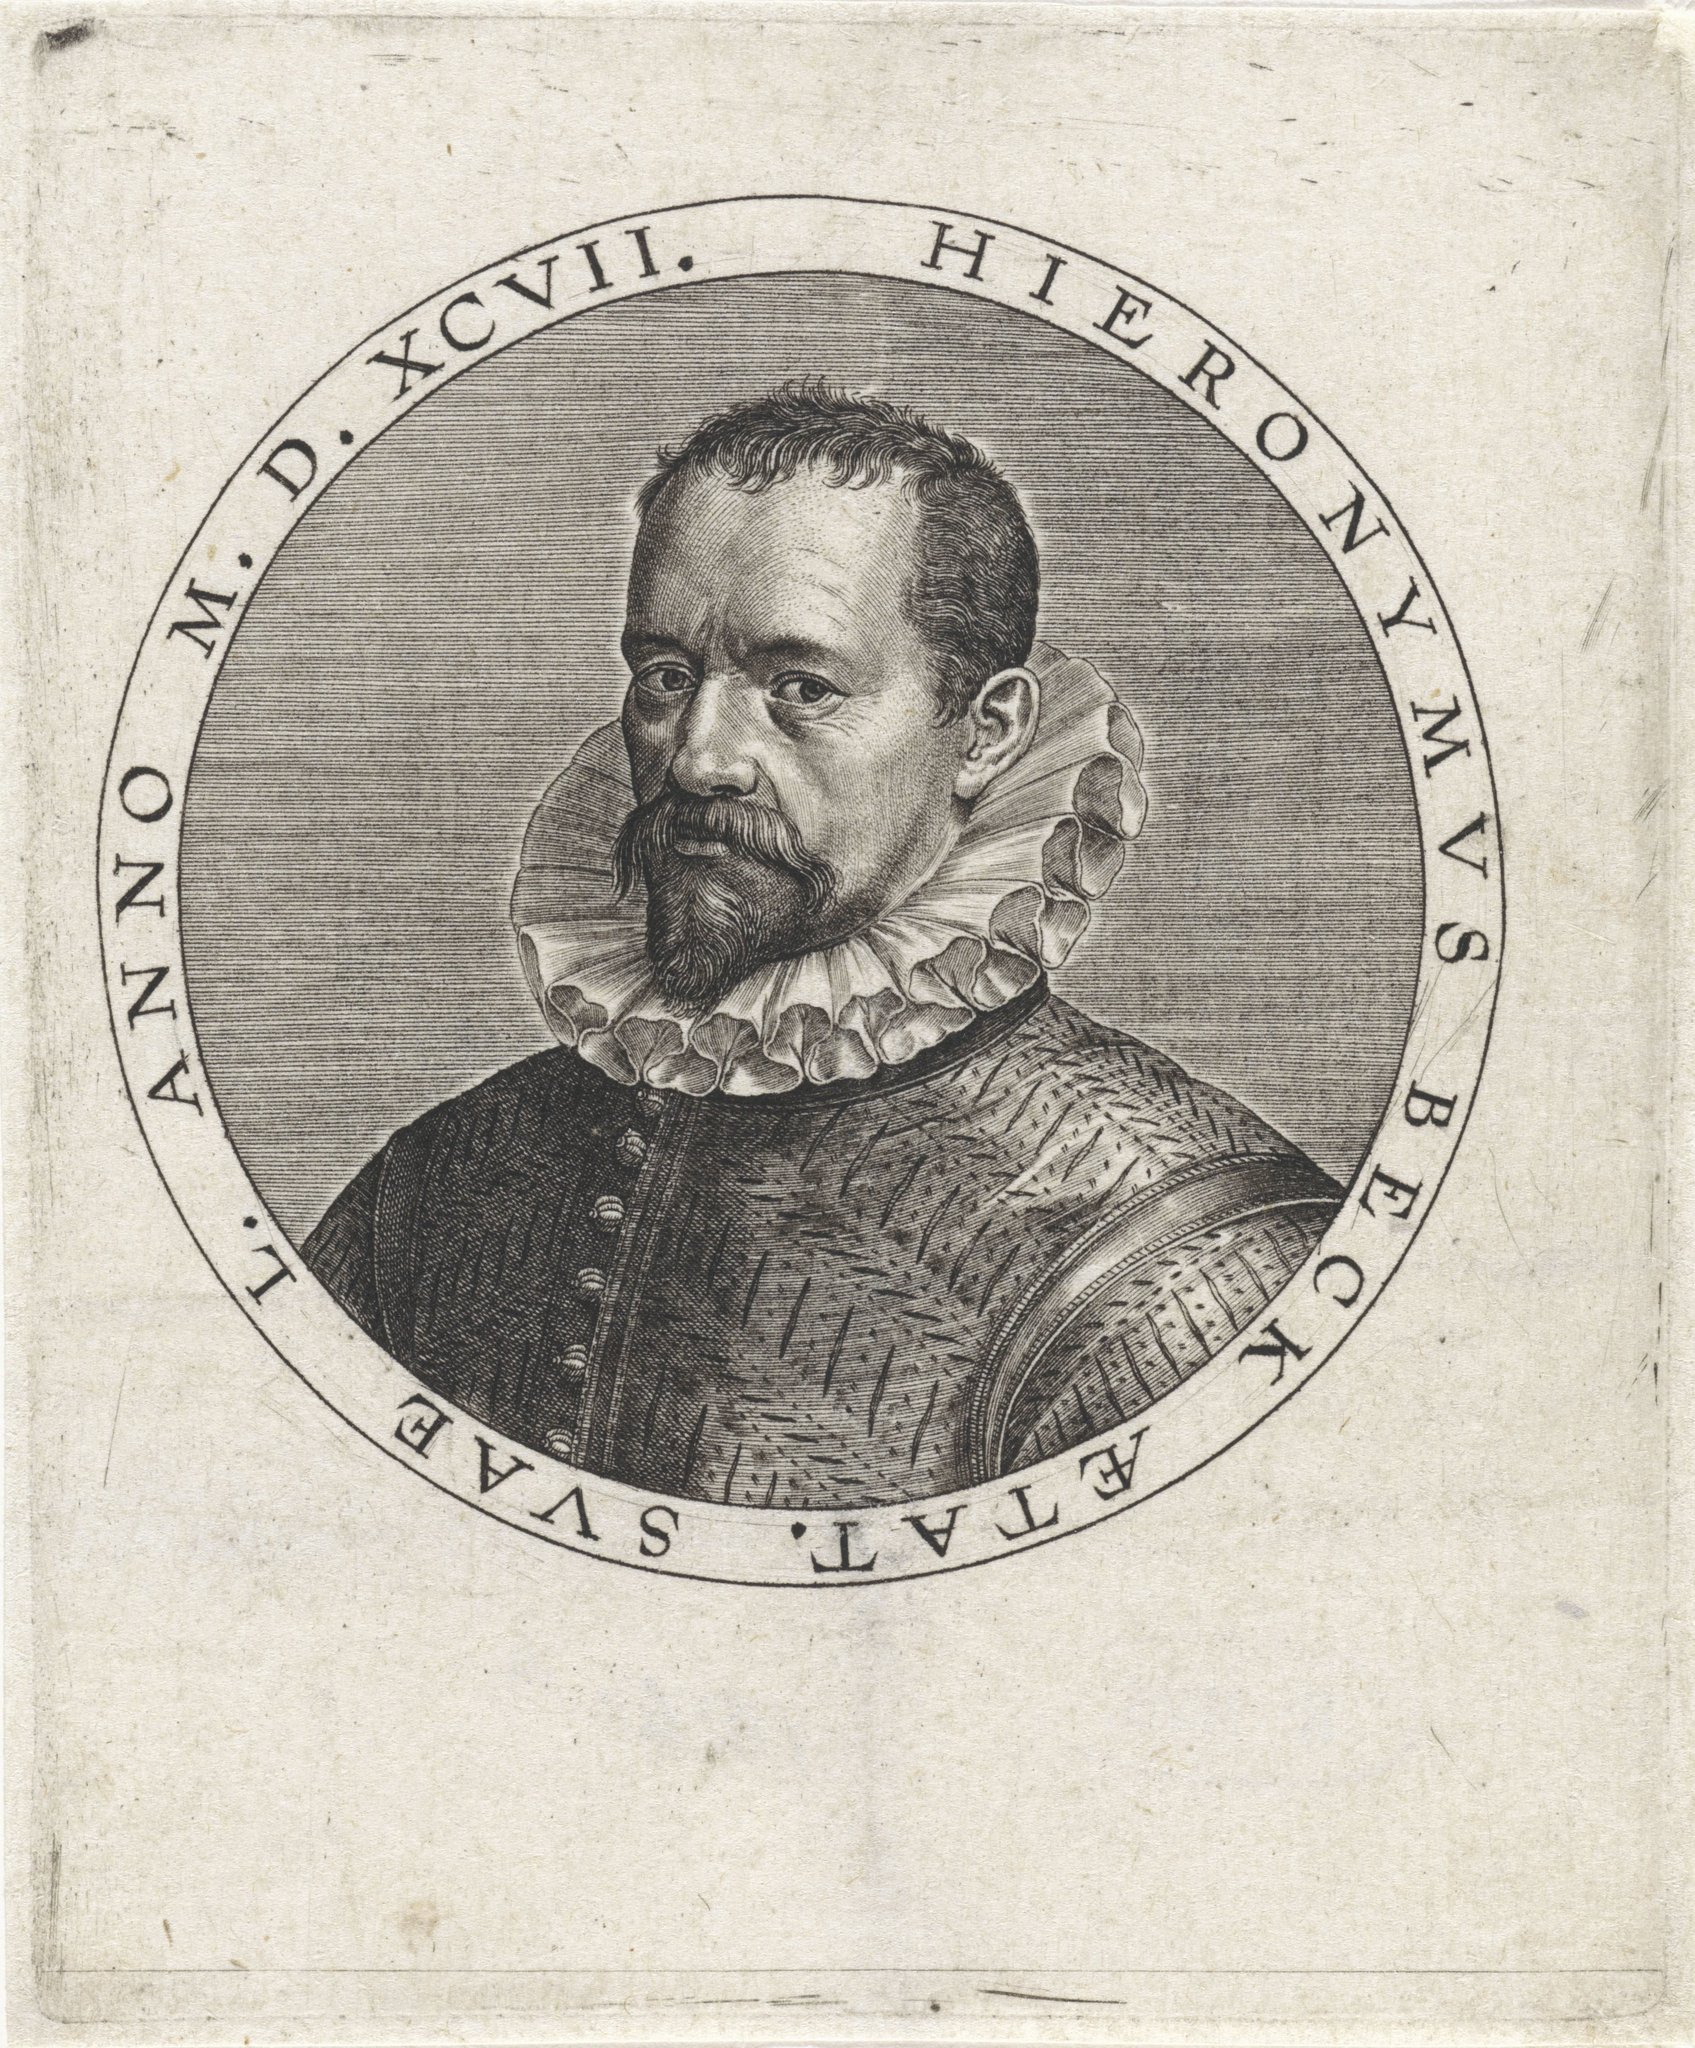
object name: print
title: Portret van Hieronymus Beck, op 50-jarige leeftijd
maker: johannes wierix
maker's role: draughtsman, print maker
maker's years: 1549-1618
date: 1597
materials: paper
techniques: engraving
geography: antwerp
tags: hieronymus beck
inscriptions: collector's mark: Lugt 2228